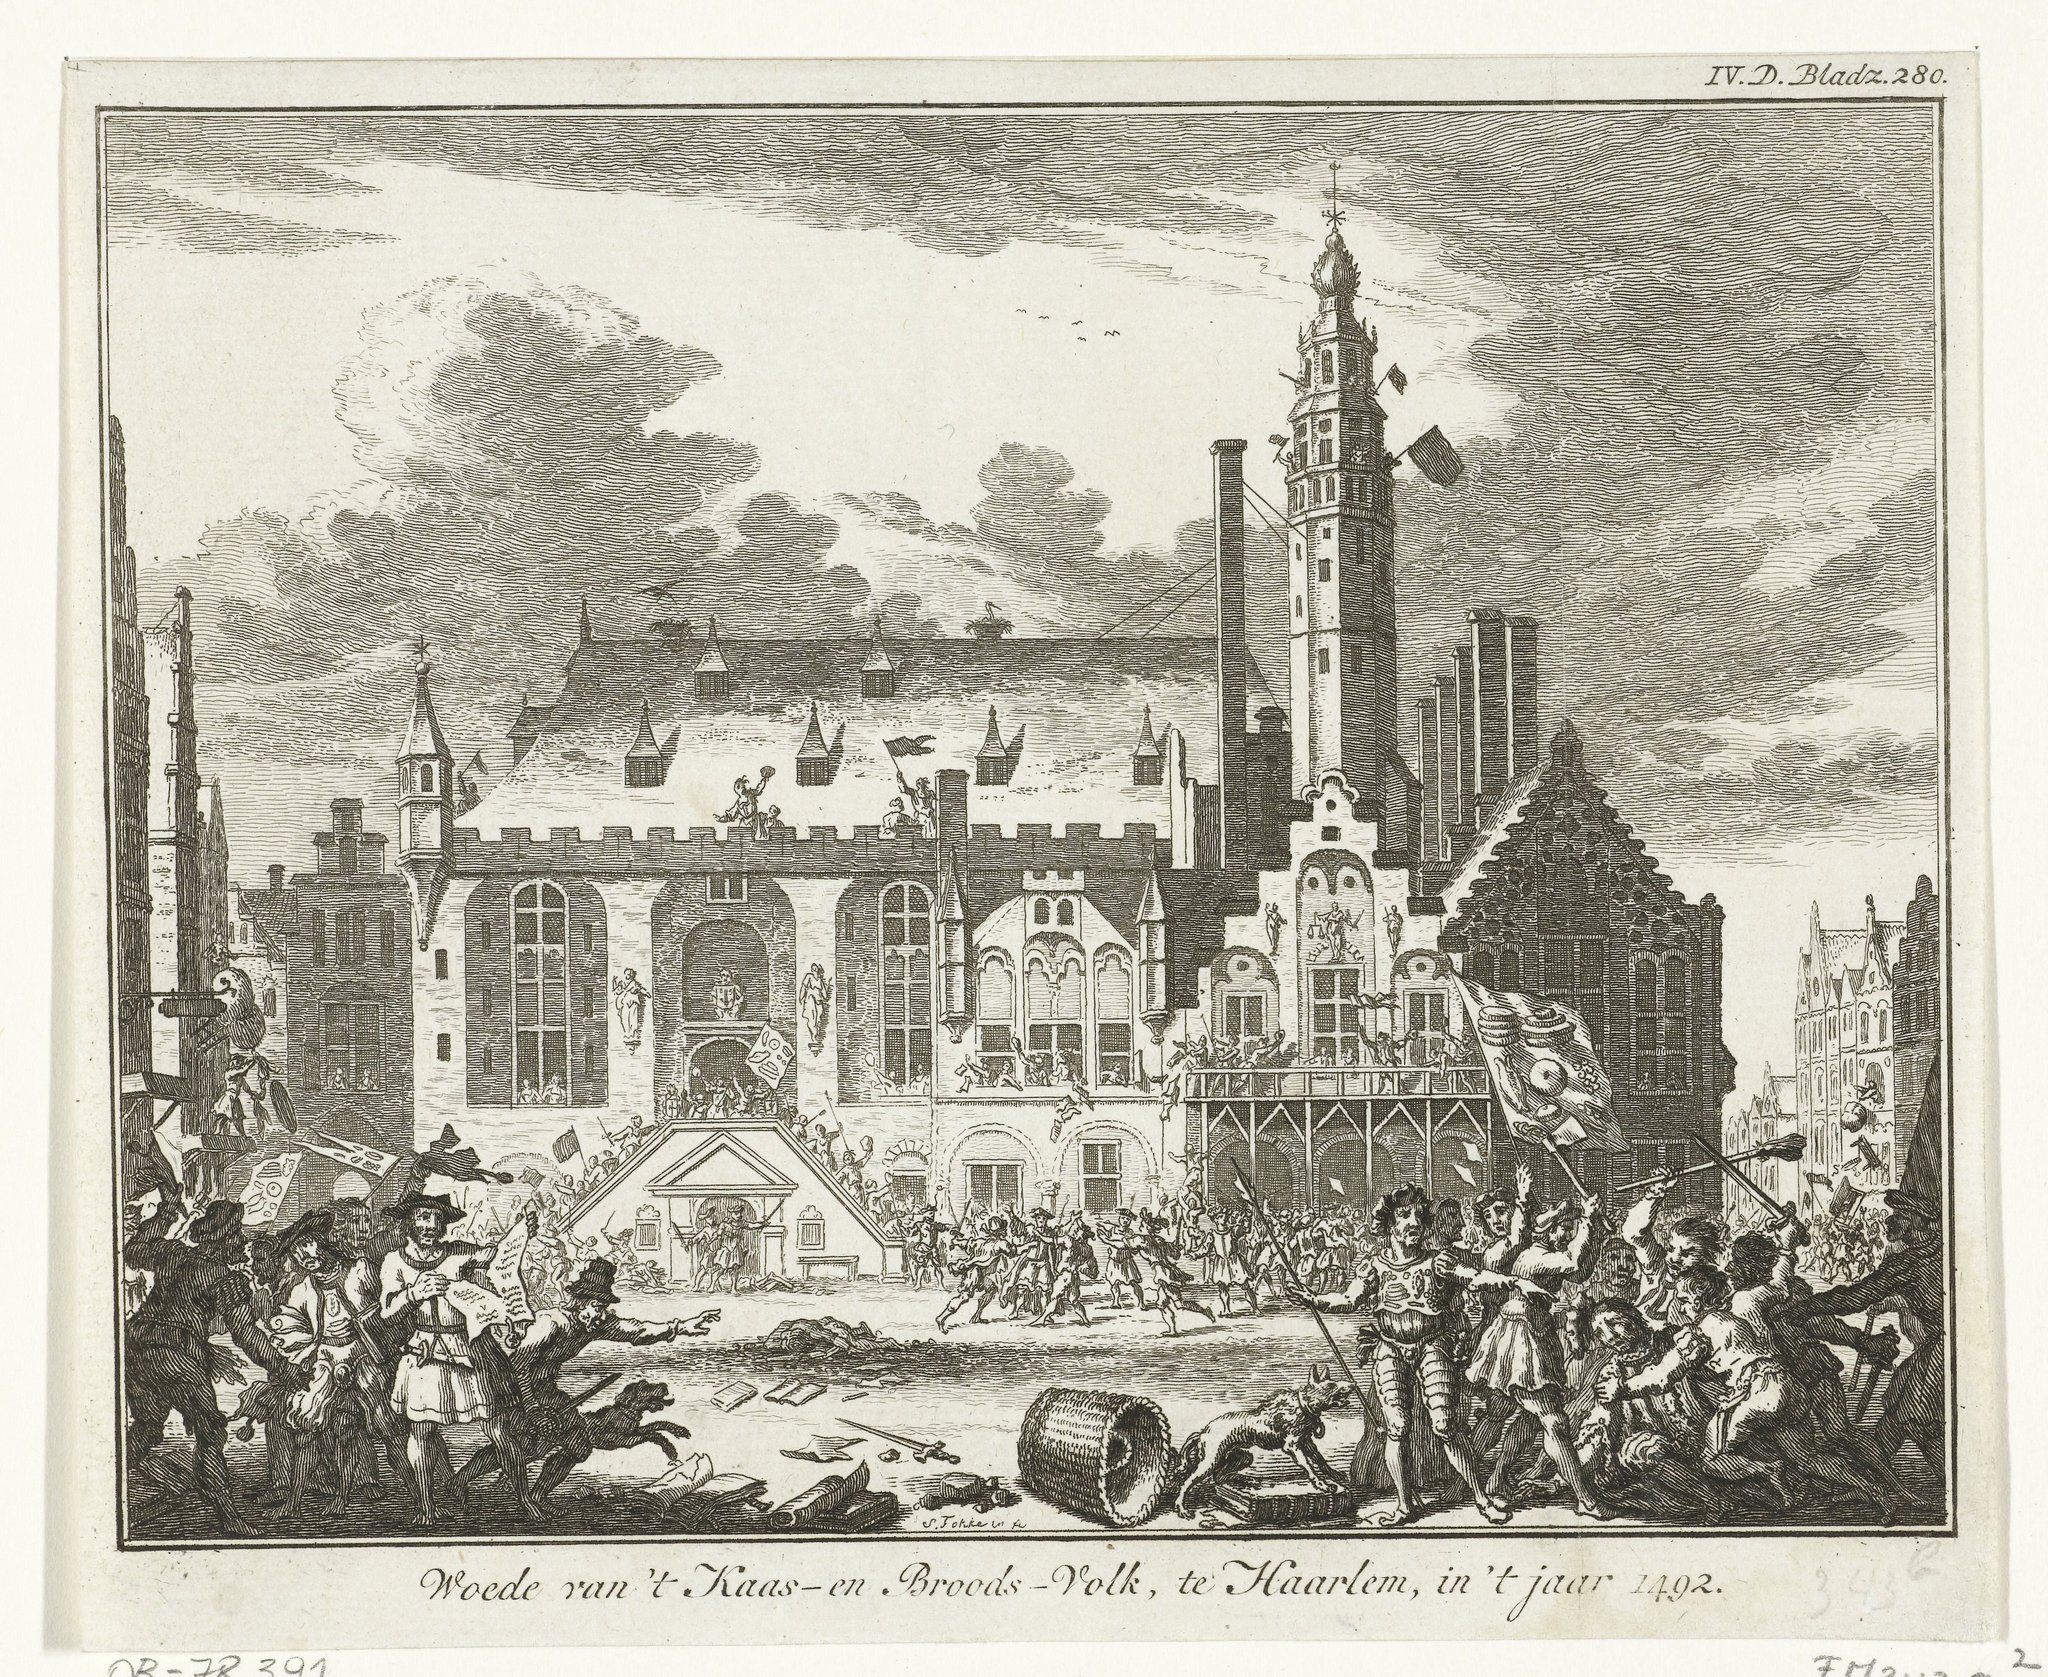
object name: print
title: Opstand van het Kaas- en Broodvolk te Haarlem, 1492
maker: Anonymous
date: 1749-1799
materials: paper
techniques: etching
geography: northern netherlands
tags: haarlem, violent death, being killed; being mishandled and maltreated; seeking death, street-fights, riots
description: Opstand van het Kaas- en Broodvolk te Haarlem, 1492. Rellen door boeren op de Grote Markt, het stadhuis wordt geplunderd. Rechts wordt baljuw Claes van Ruyven vermoord.